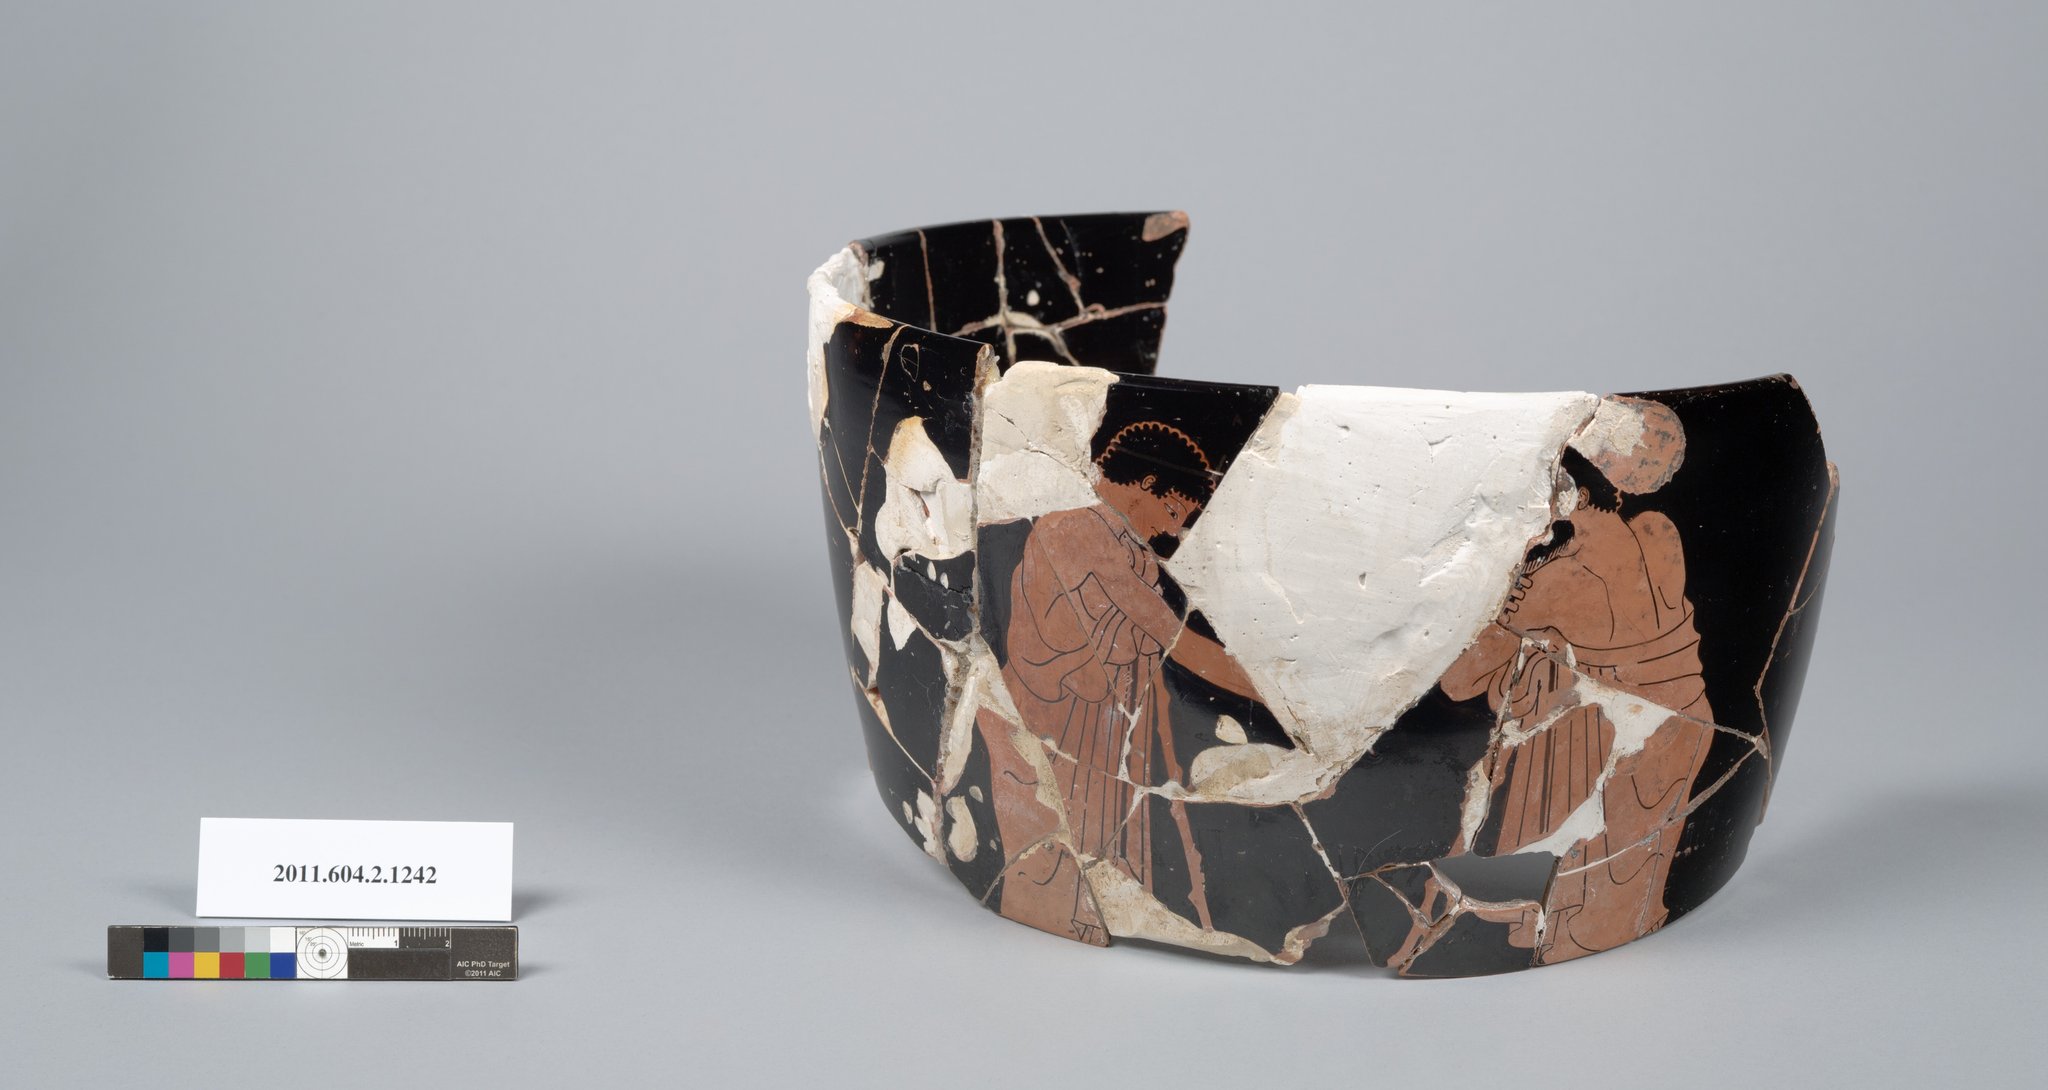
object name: skyphos fragment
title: Terracotta fragment of a skyphos (deep drinking cup)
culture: greek, attic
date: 500-480 BCE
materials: terracotta